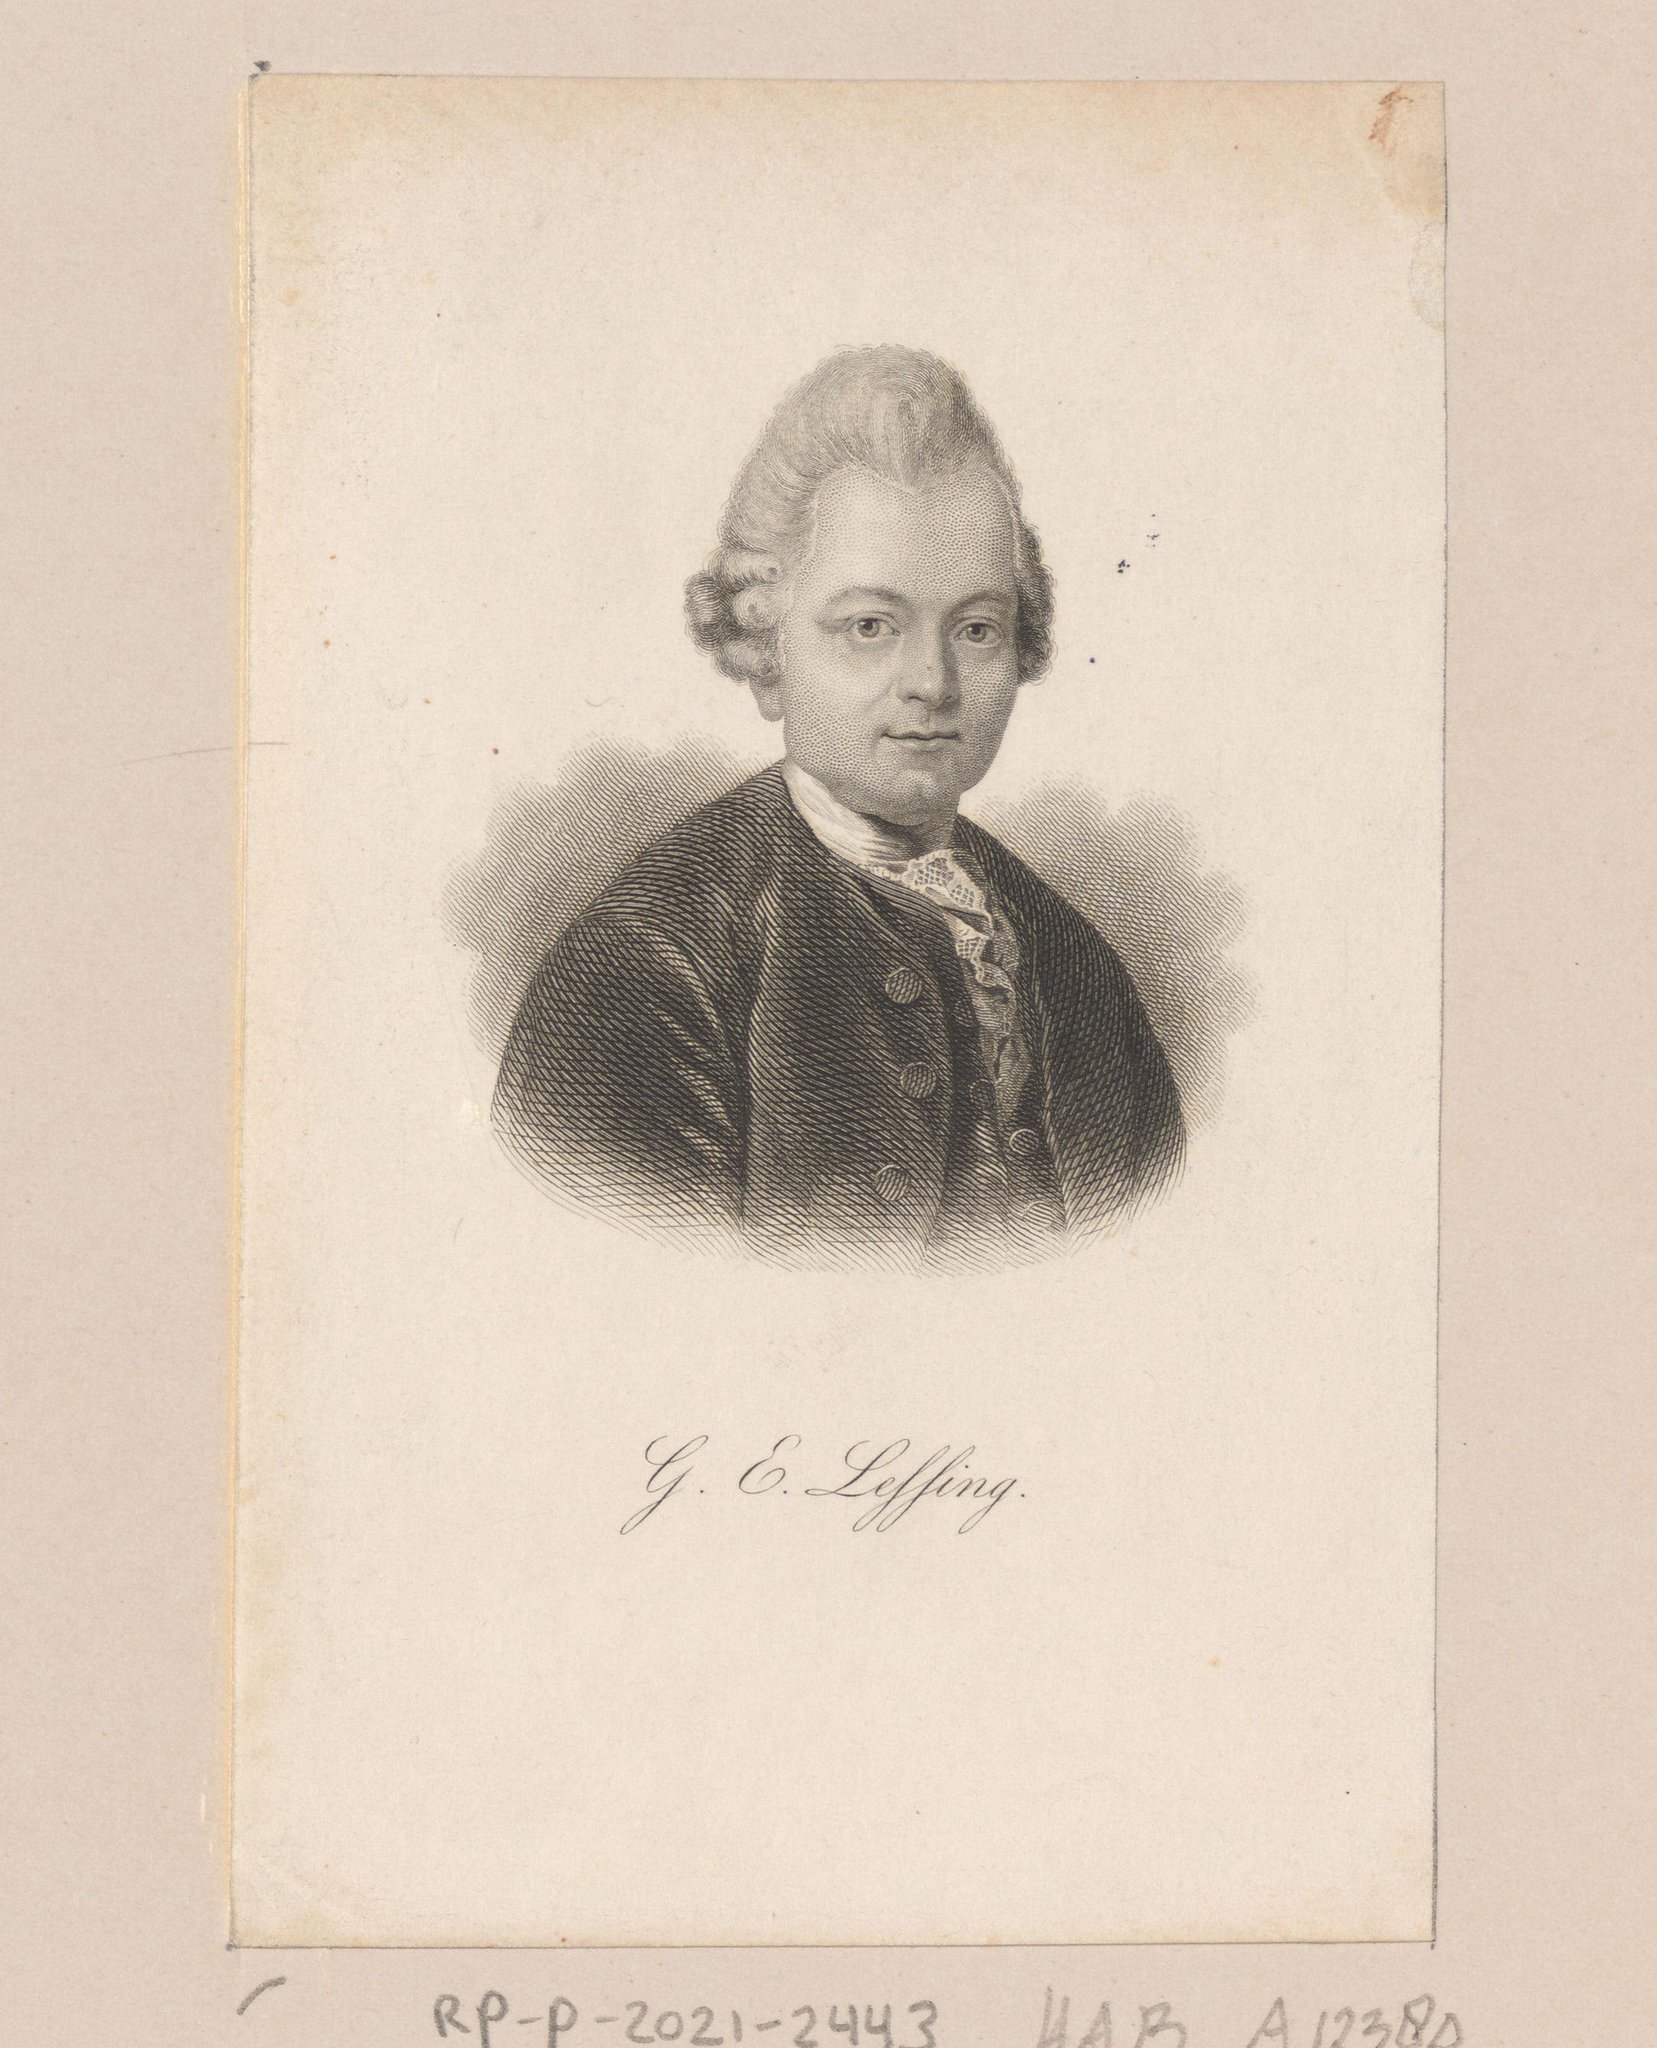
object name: print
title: Portret van Gotthold Ephraim Lessing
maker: Anonymous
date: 1820-1899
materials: paper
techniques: etching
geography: germany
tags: historical persons, portrait of a writer, wig